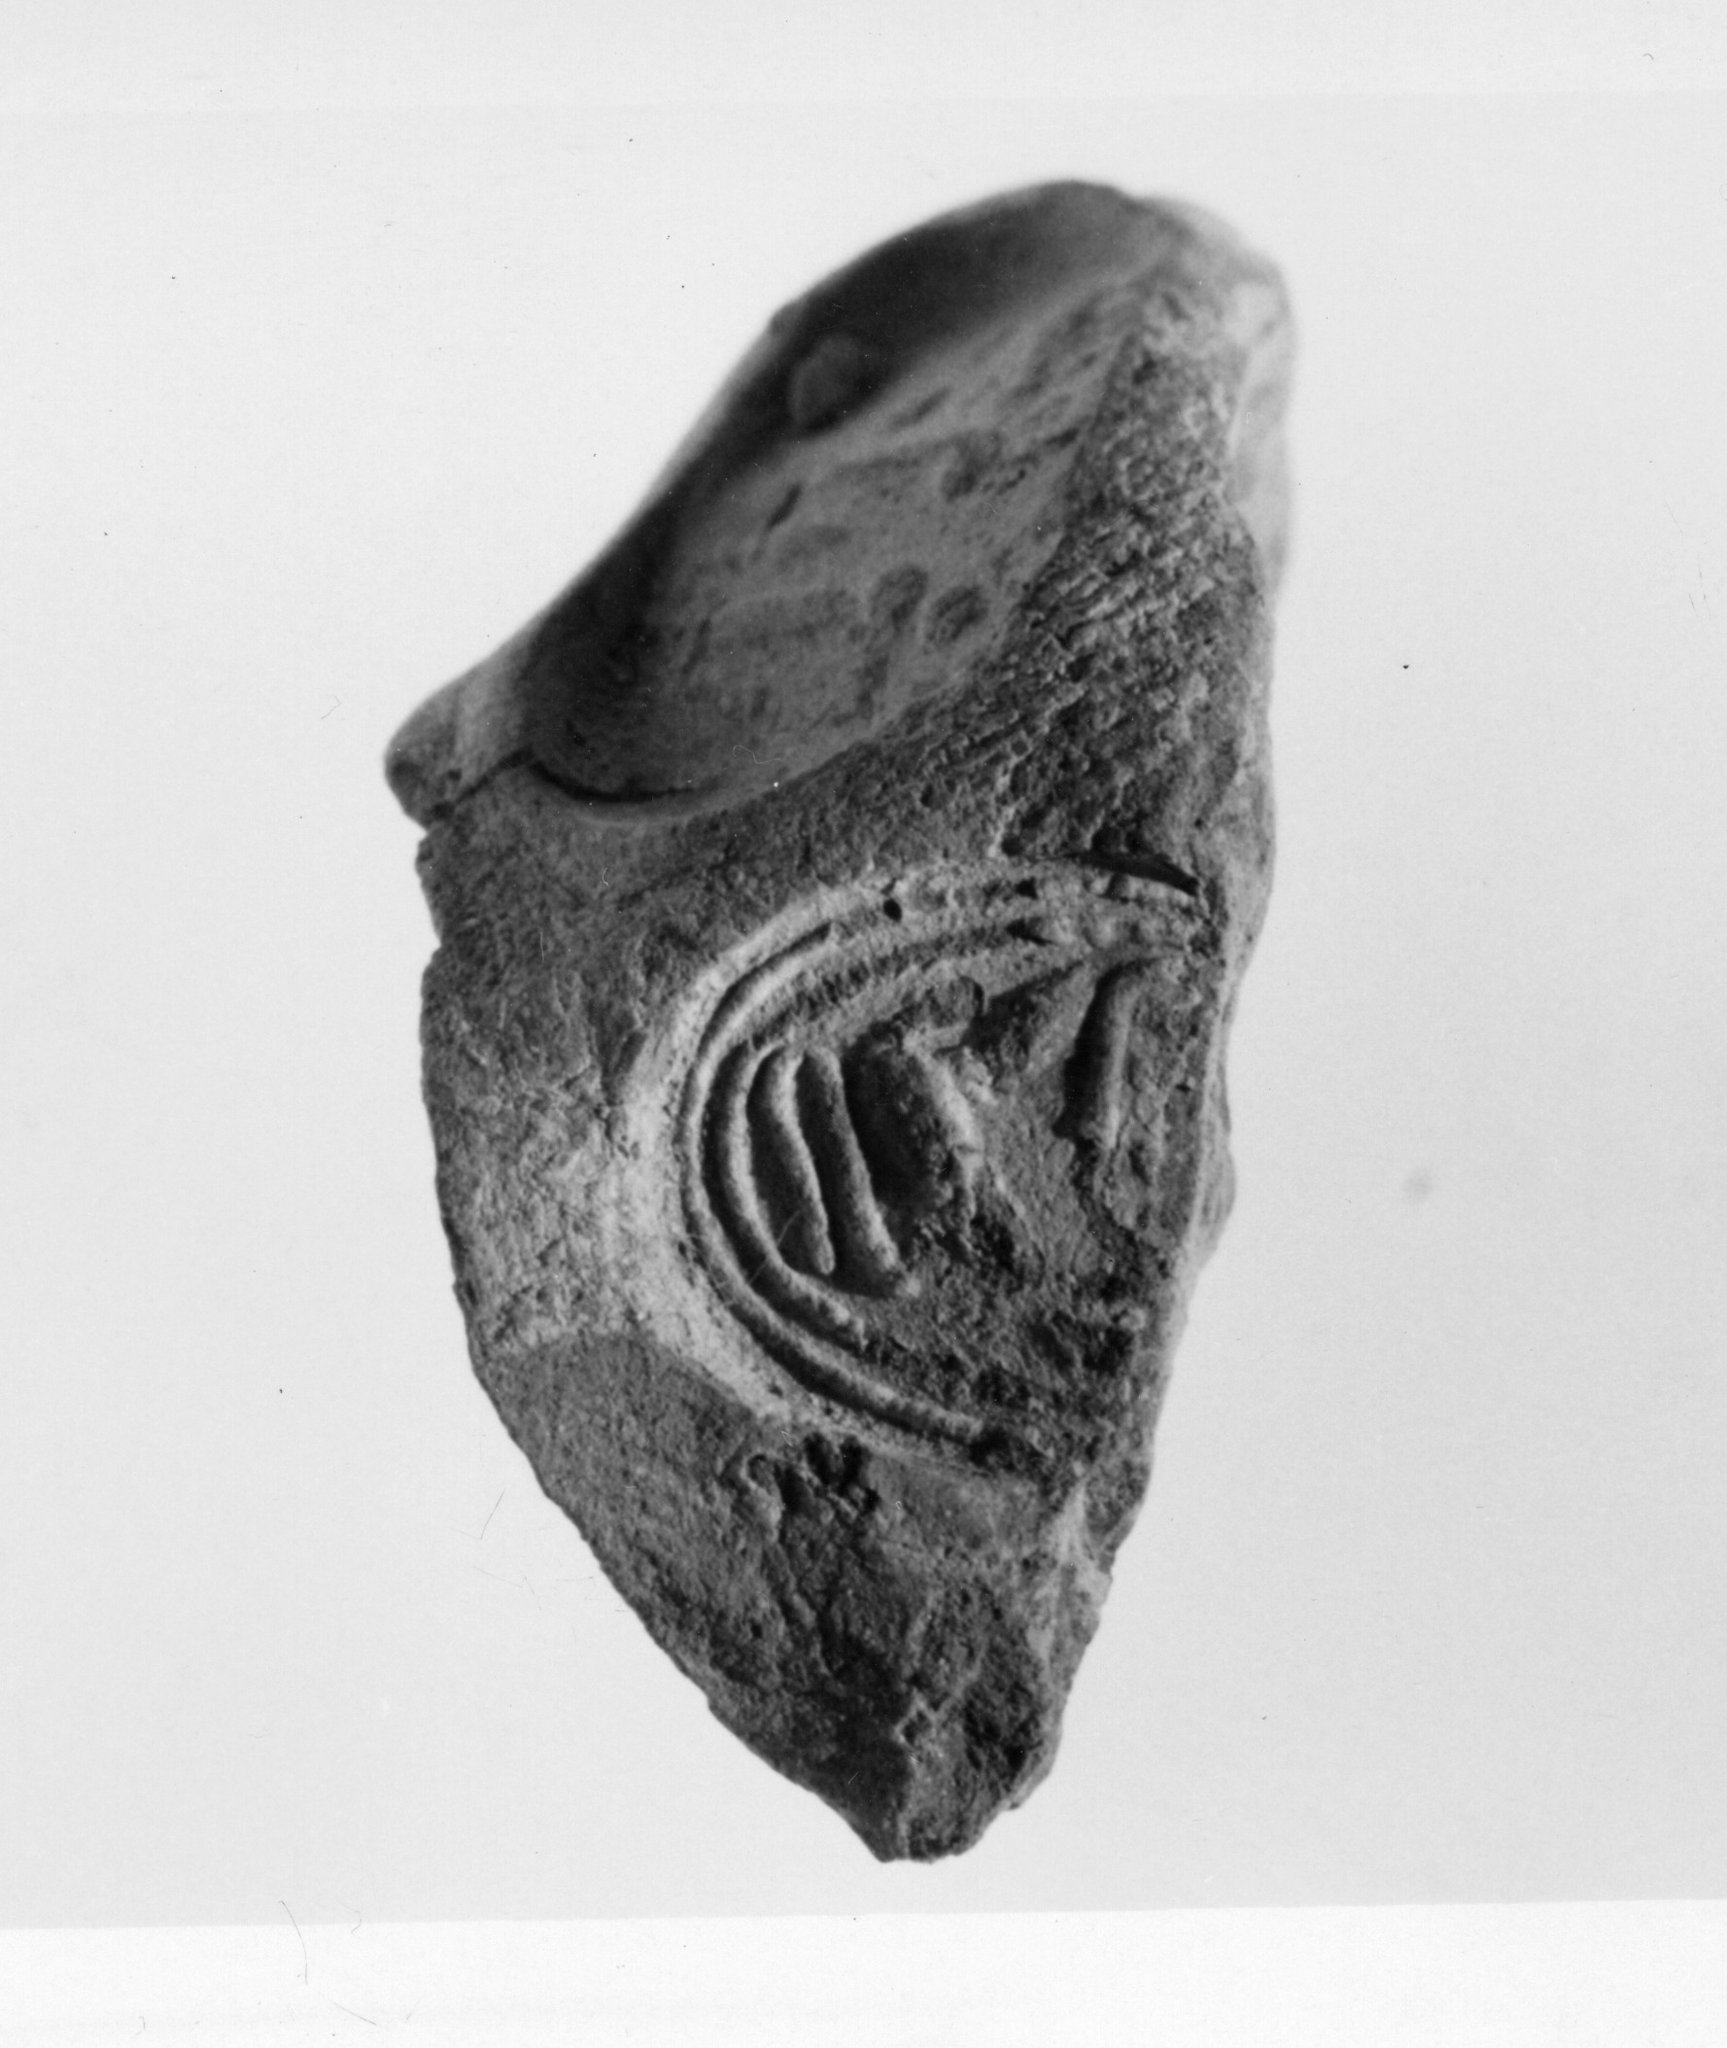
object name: sealing, amenhotep iii, nebmaatre, cobra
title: Document Sealing With Multiple Seal Impressions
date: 1390-1352 BCE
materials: mud